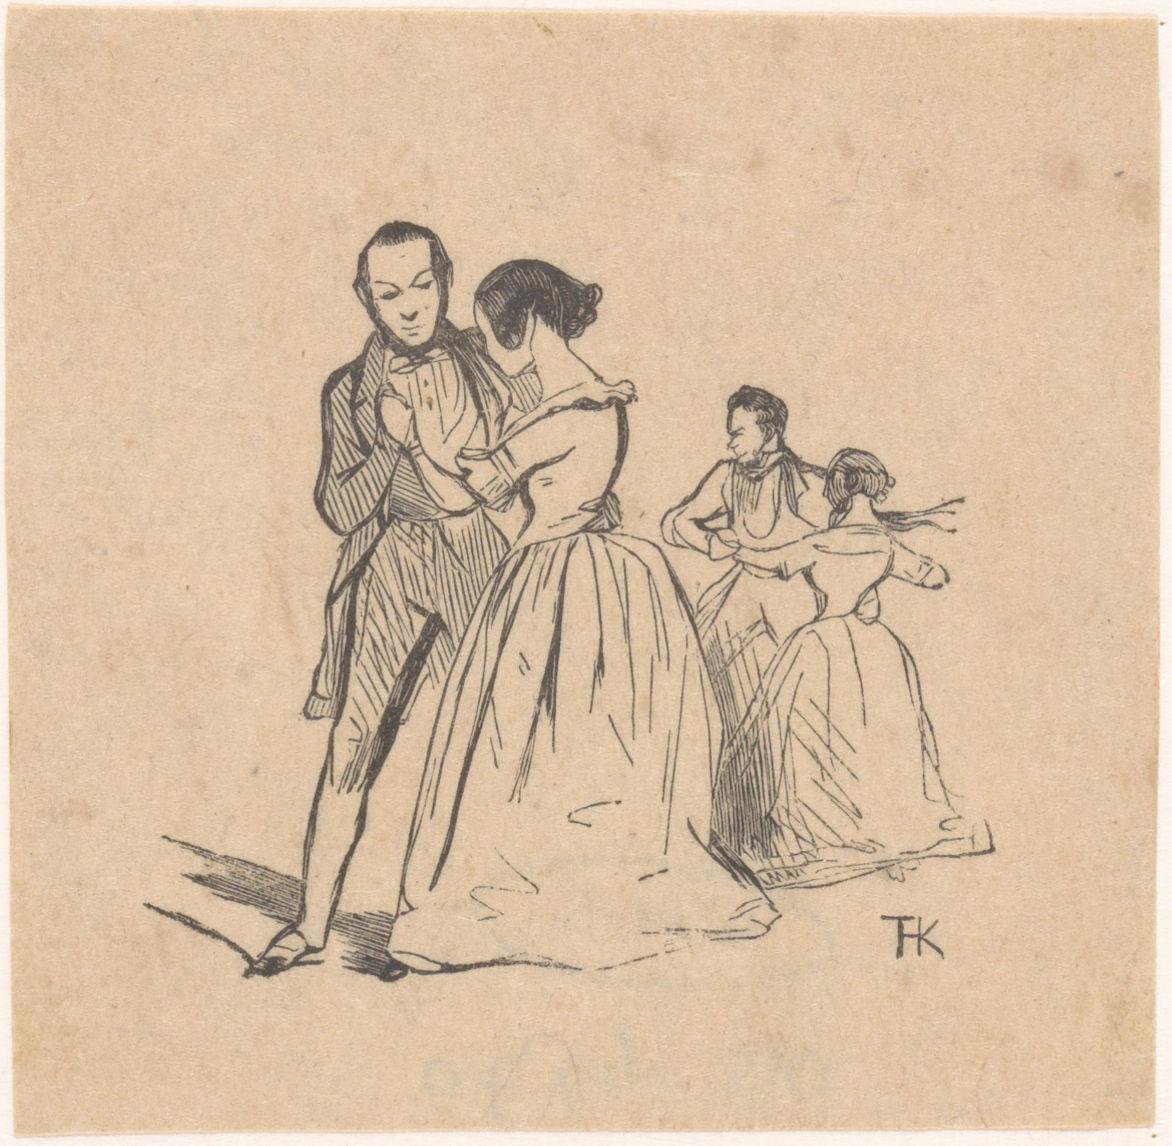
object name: print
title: Dansende man en vrouw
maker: theodorus henricus kerstel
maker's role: print maker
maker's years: 1859-1936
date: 1869-1936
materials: paper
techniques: line block, engraving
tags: one pair dancing; man and woman dancing as a couple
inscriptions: collector's mark: Lugt 2228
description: Op de achtergrond nog een dansende man en vrouw.